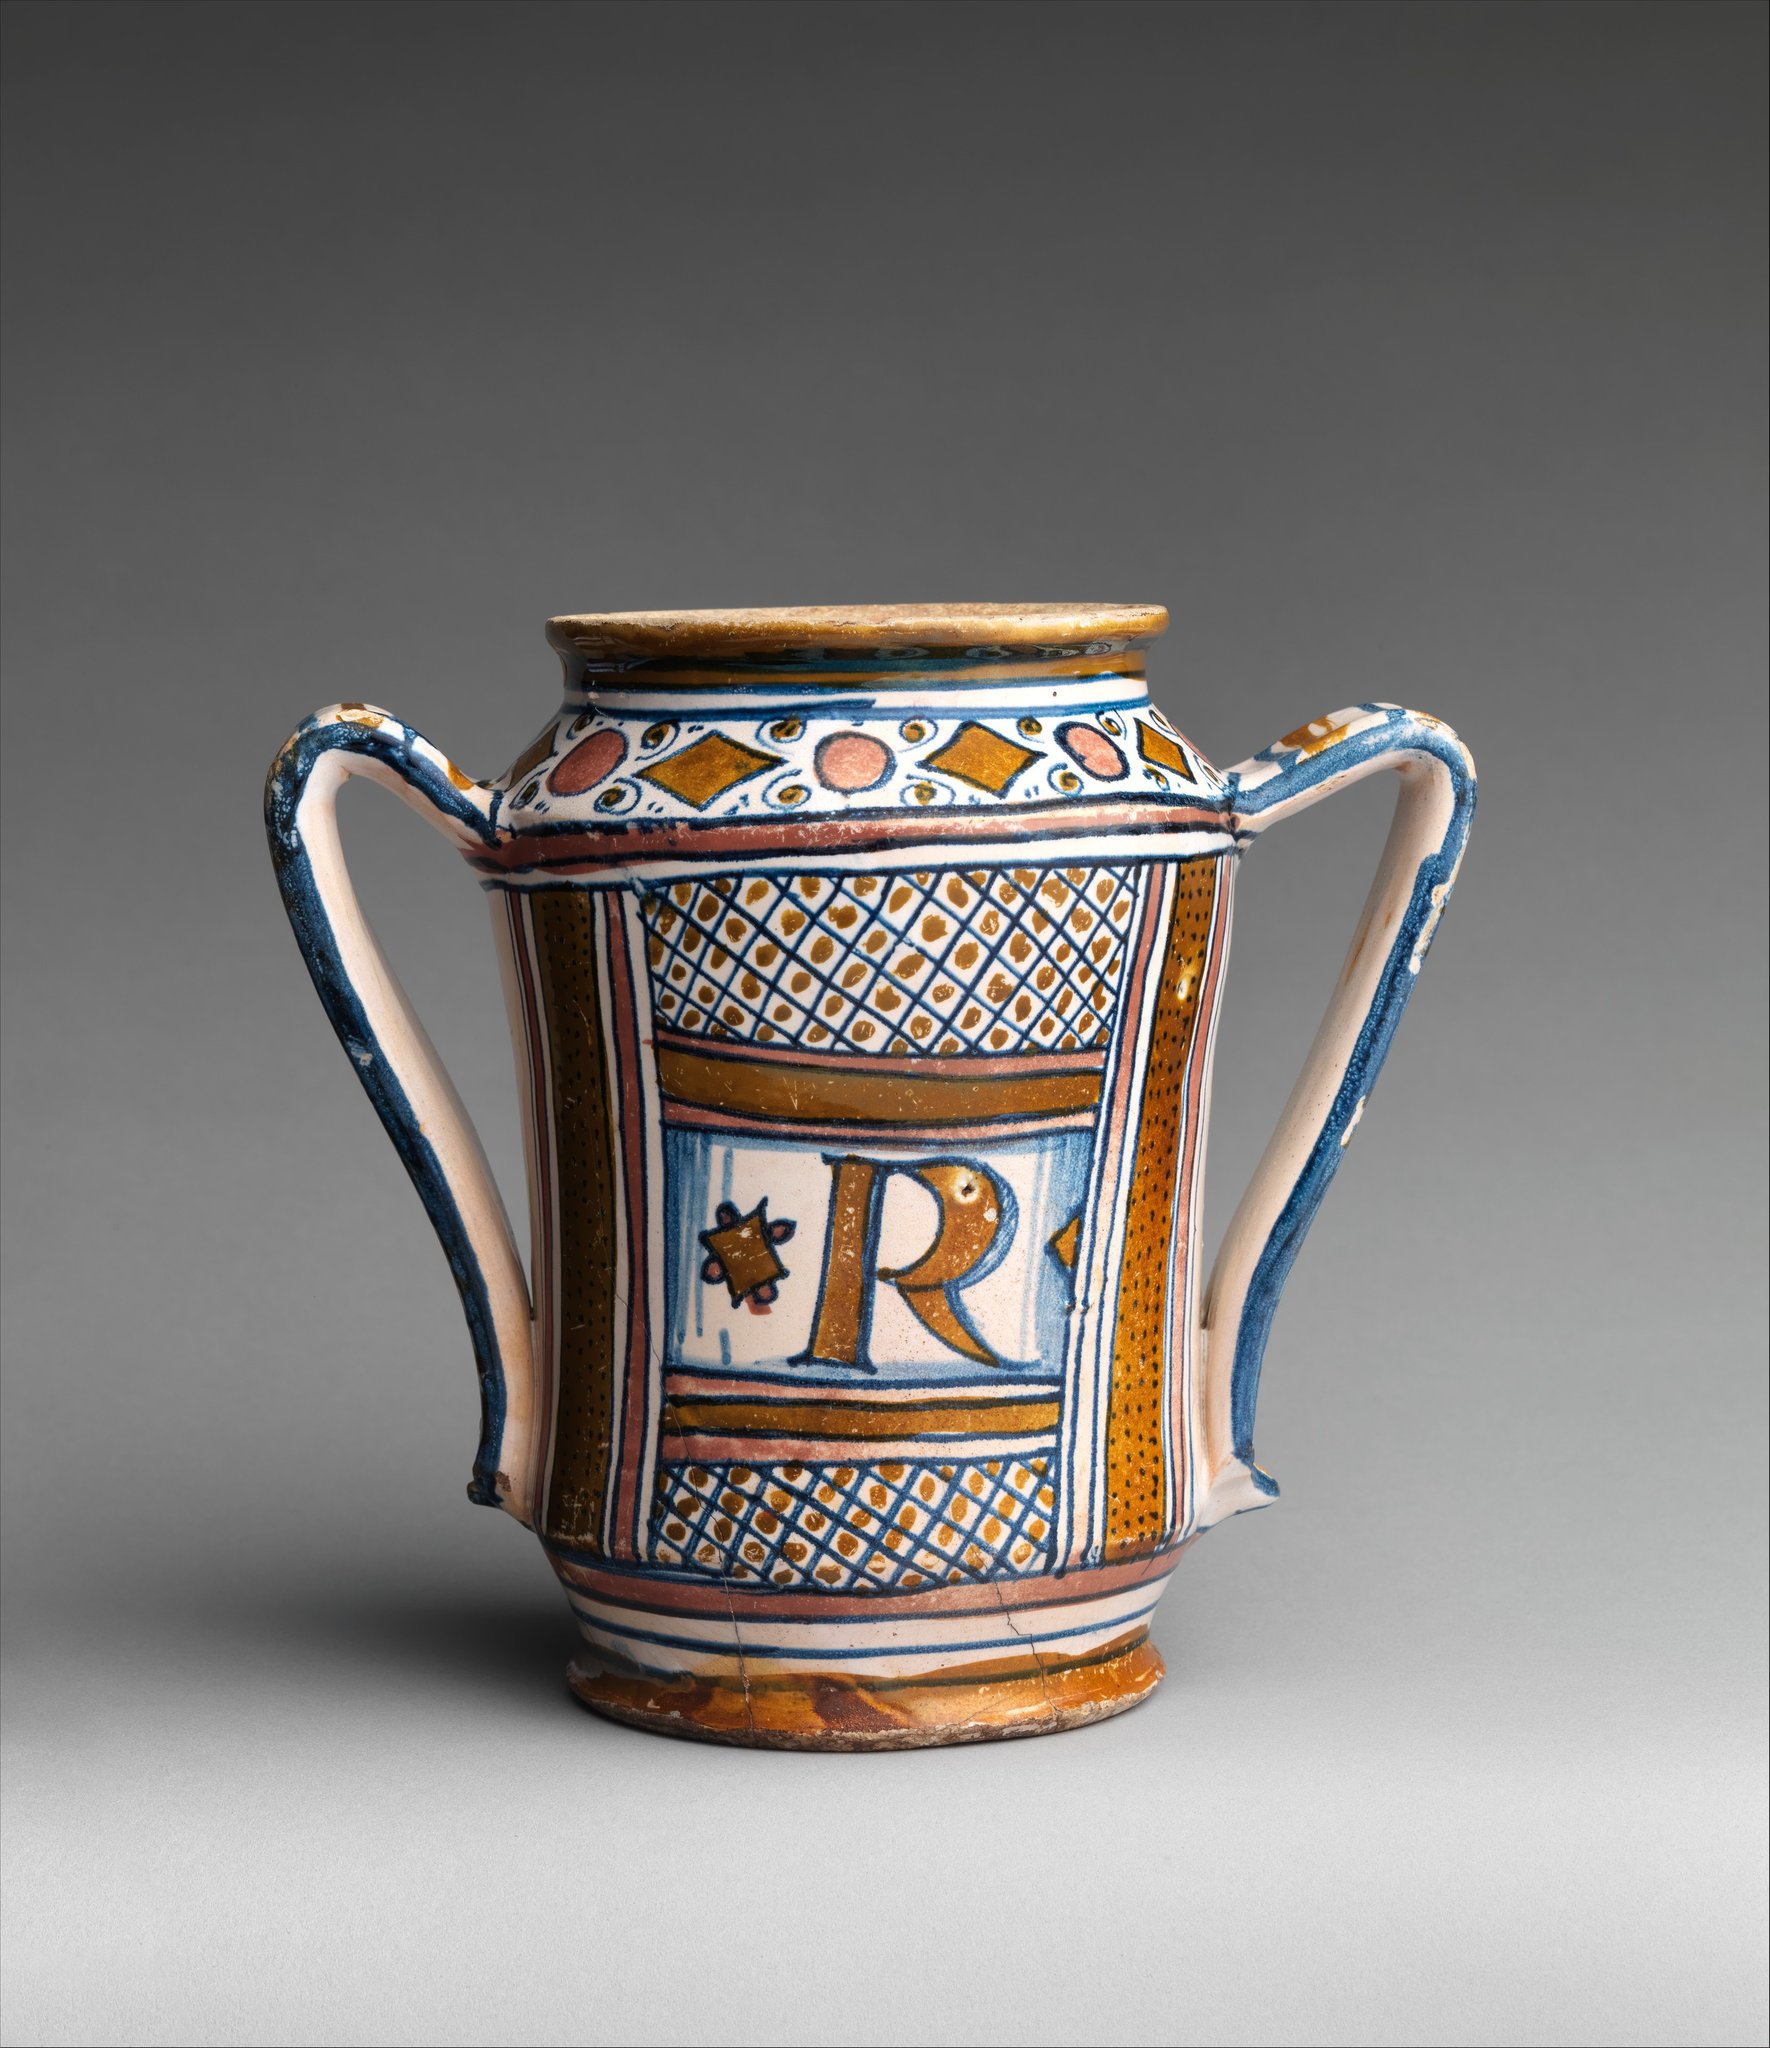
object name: vase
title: Two-handled vase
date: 1495-1510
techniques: maiolica, glazing